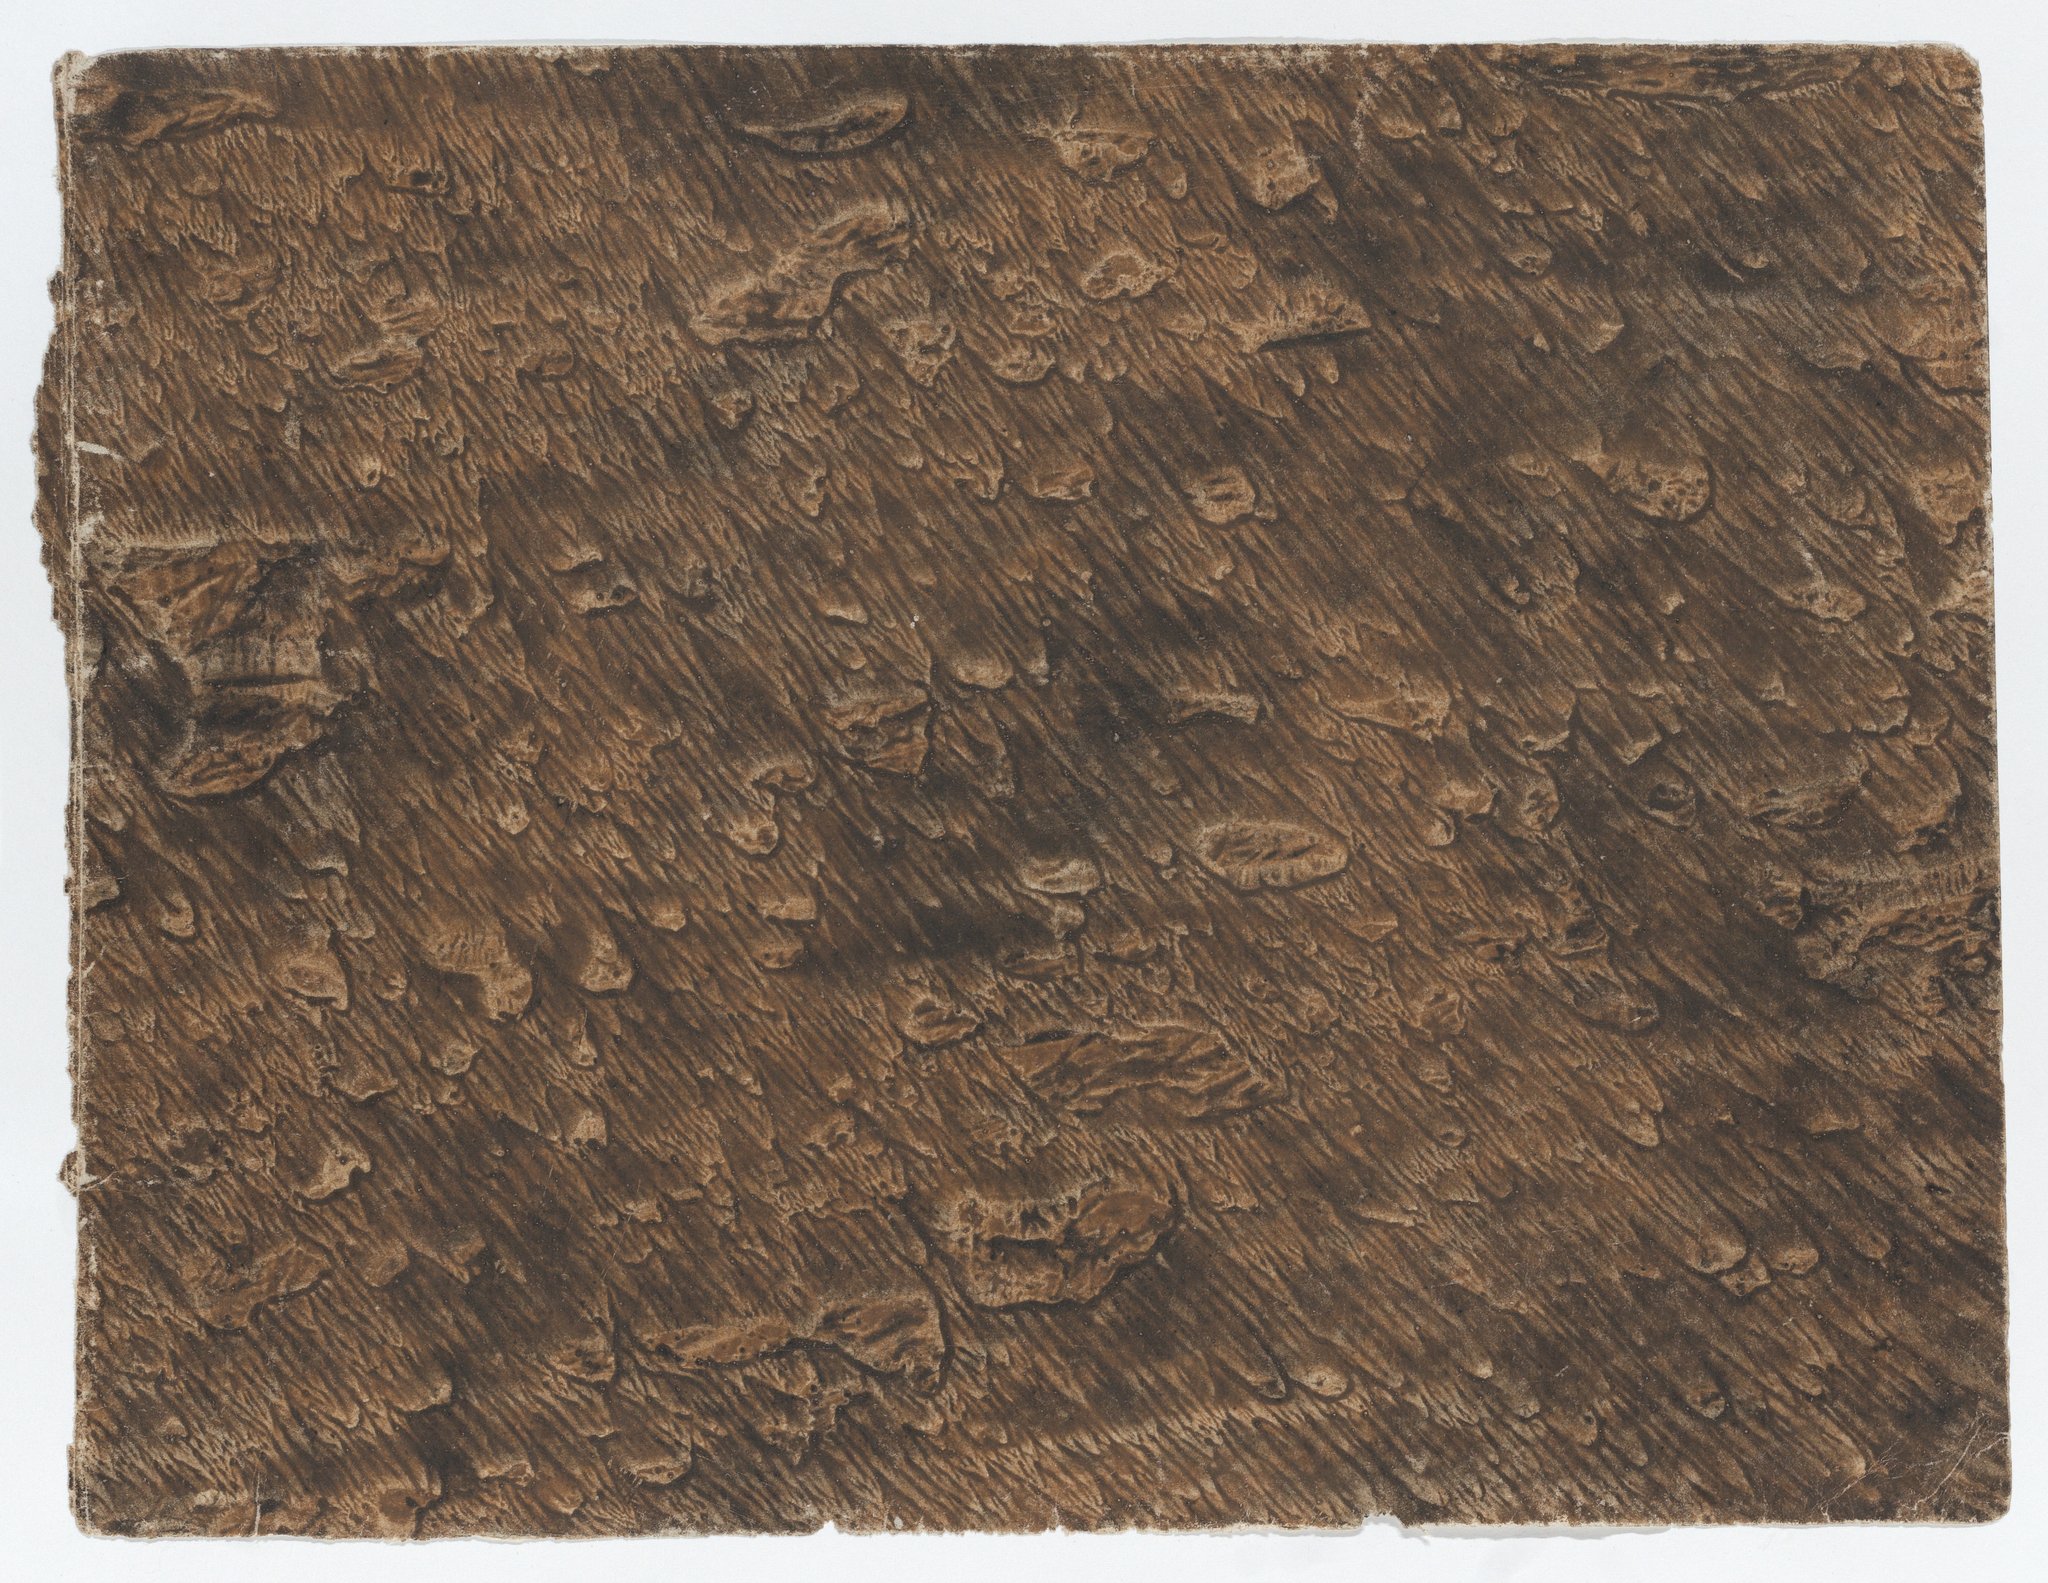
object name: print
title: Paste paper with brown design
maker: Anonymous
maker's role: artist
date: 1701-1800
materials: paper, paste